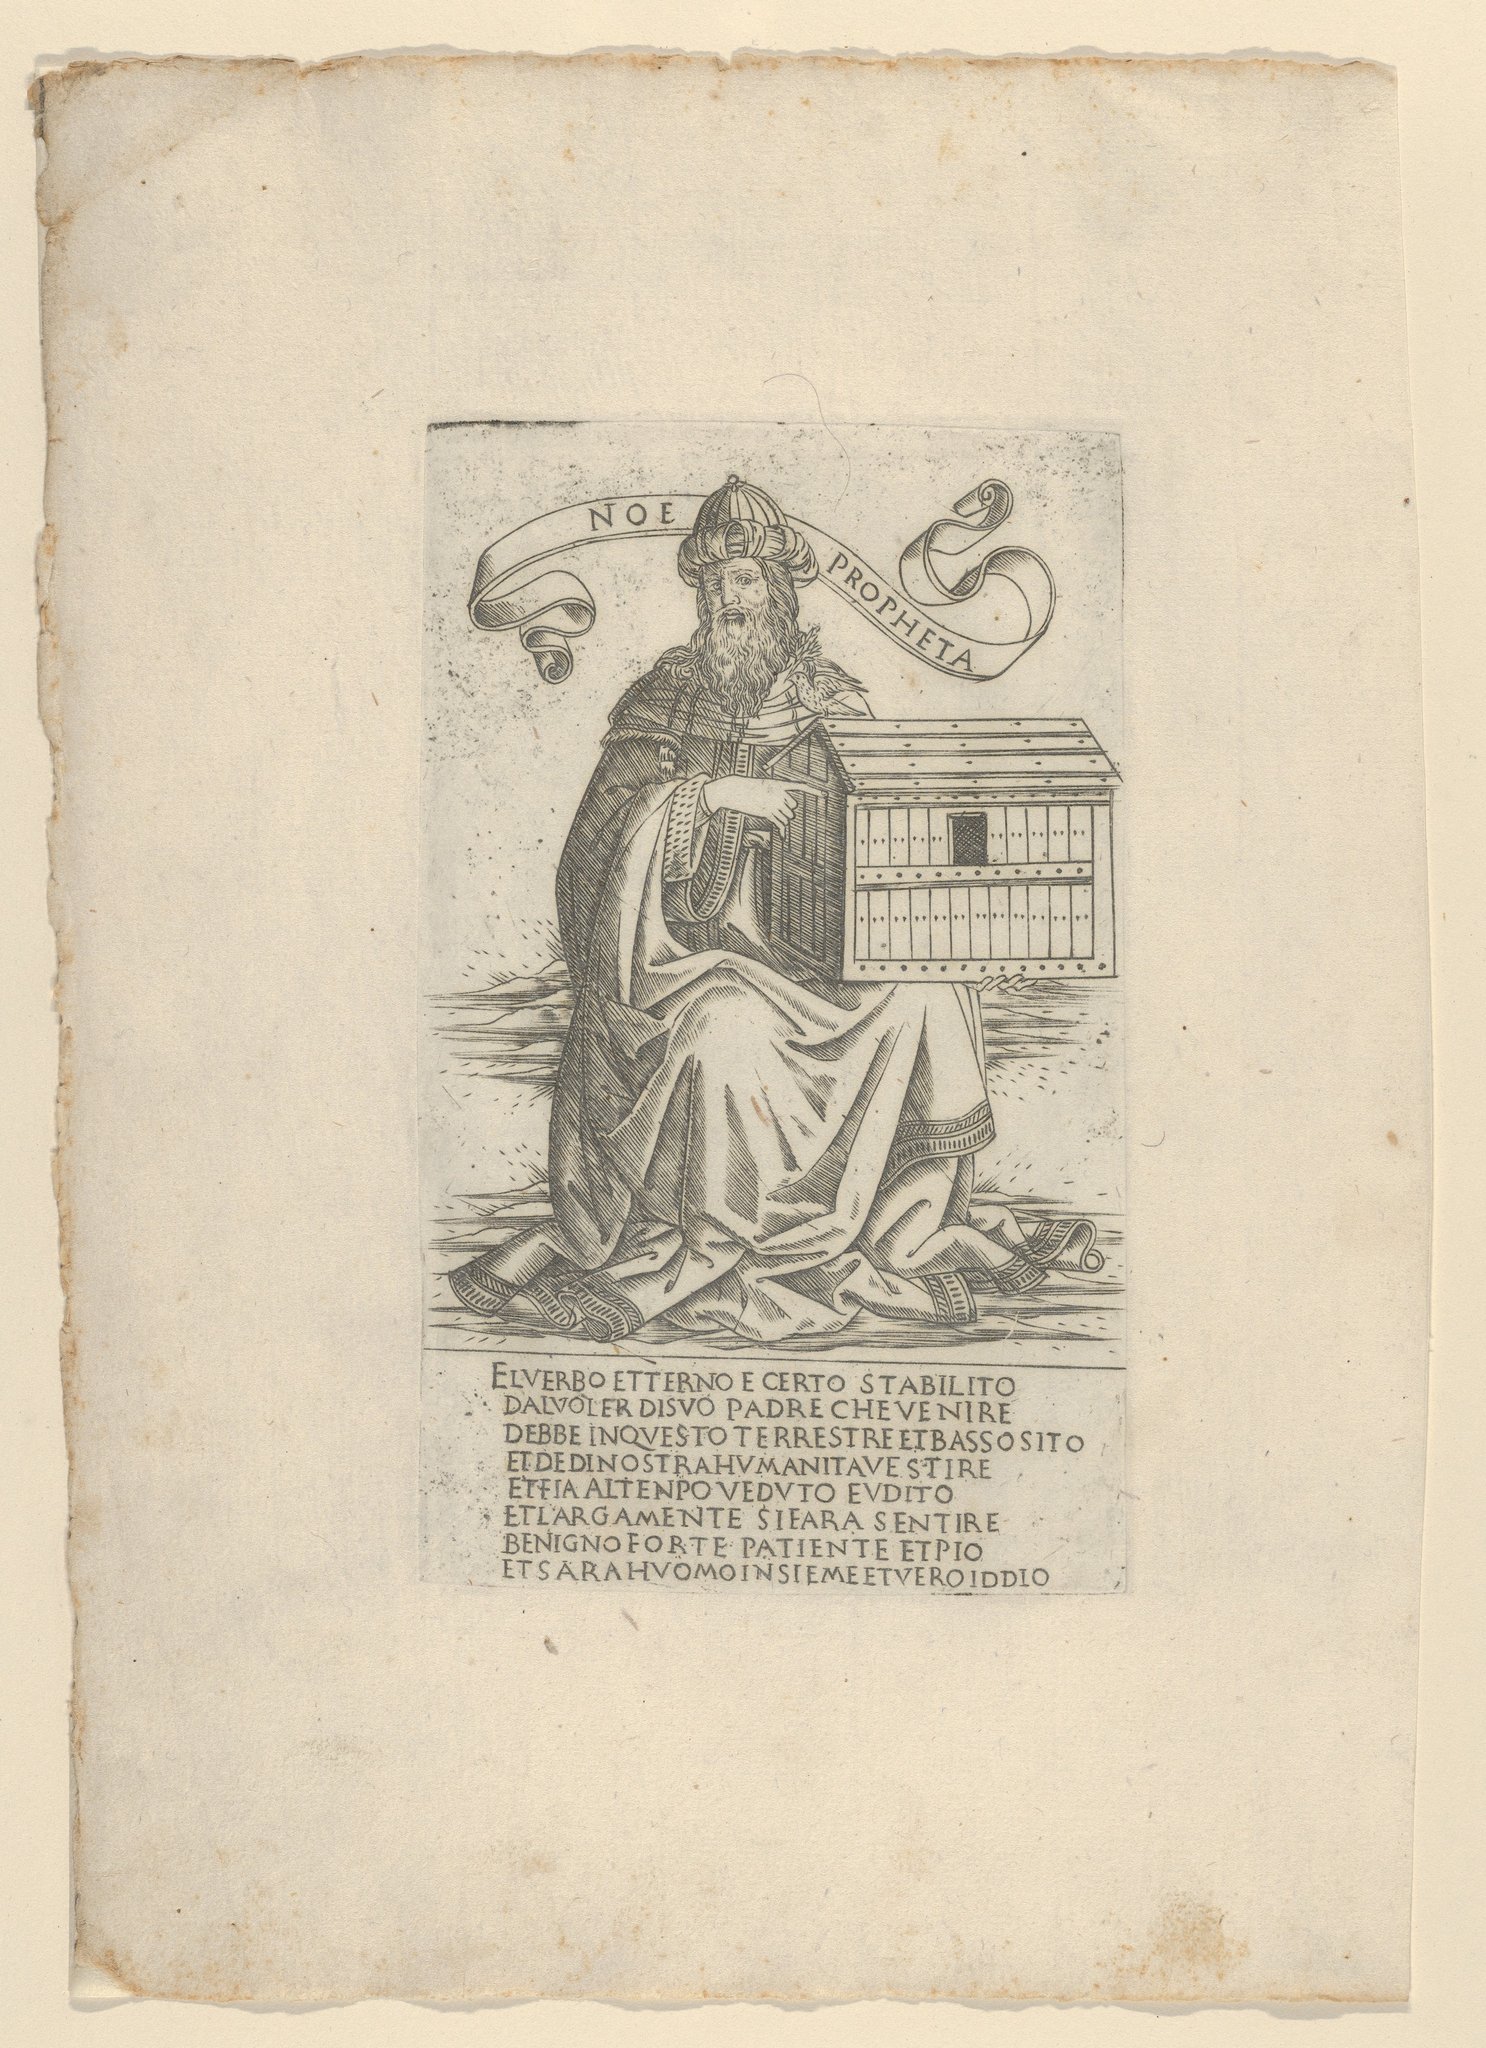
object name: print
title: The Prophet Noah, from Prophets and Sibyls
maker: francesco rosselli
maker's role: artist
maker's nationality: italian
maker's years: 1448-1527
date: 1480-1490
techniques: engraving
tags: men